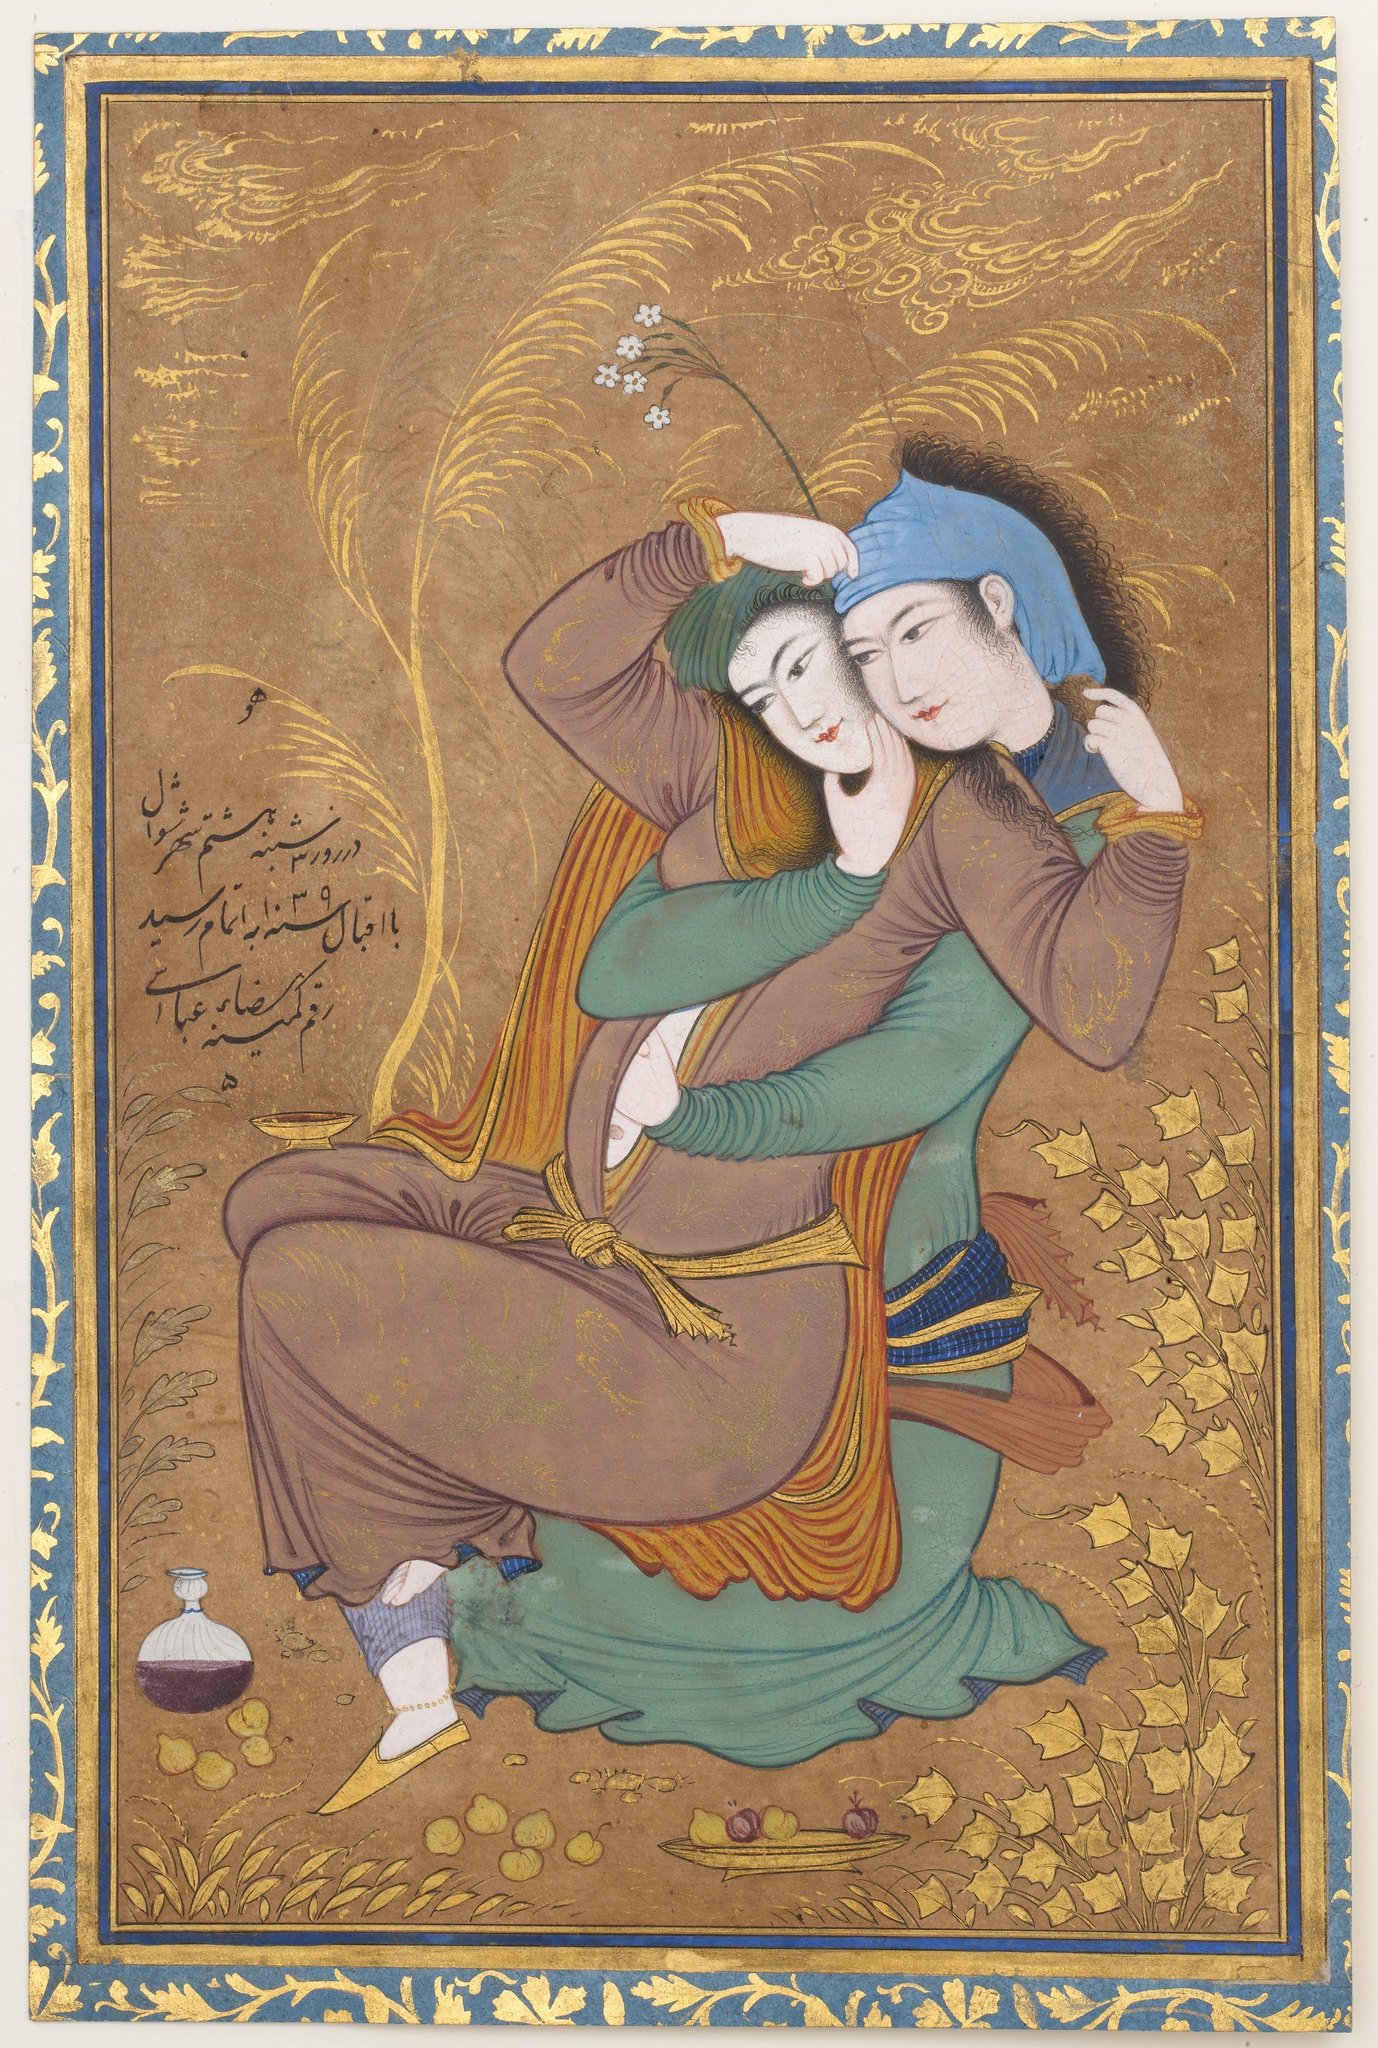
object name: illustrated single work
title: The Lovers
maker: riza-yi 'abbasi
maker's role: artist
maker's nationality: iranian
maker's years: 1540-1660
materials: gold, ink, paper, watercolor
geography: iran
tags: couples,men,women